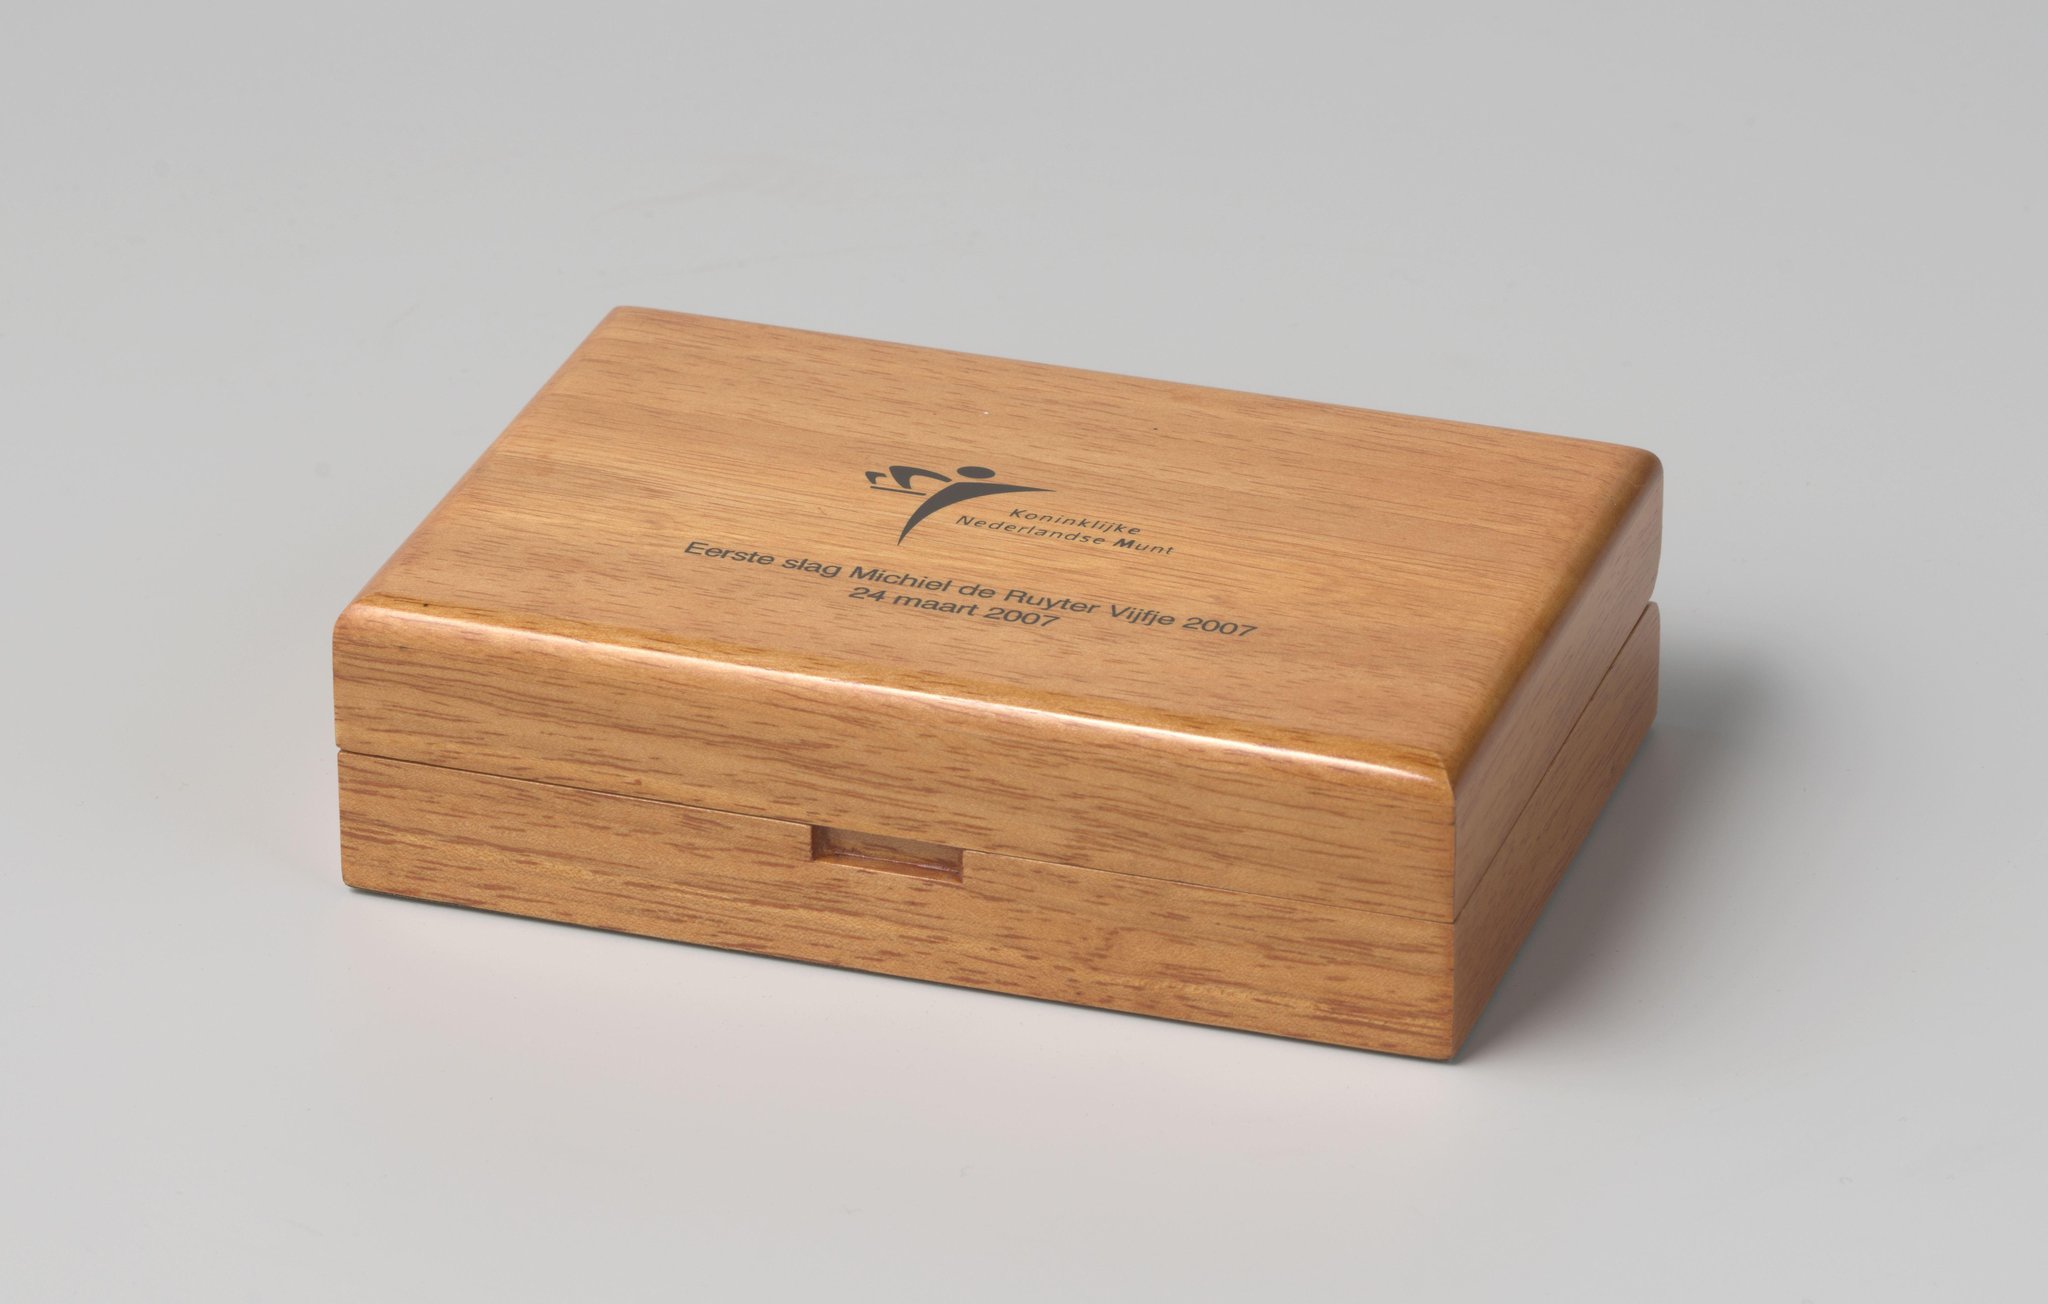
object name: box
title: Houten doosje bij munt Michiel de Ruyter Vijfje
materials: metal, paper, velvet, wood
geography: utrecht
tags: flushing, michiel adriaenszoon de ruyter, netherlands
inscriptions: inscription: ‘Eerste slag Michiel de Ruyter Vijfje 2007 24 maart 2007’, inscription: ‘Koninklijke Nederlandse Munt’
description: Houten doosje met scharnierend deksel met opschrift. Onderzijde mosgroen fluweel. Binnenzijde blauw fluweel met uitsparing voor munt en in de deksel een uitsparing met elastiek voor inlegvelletje waarop informatie over de munt.